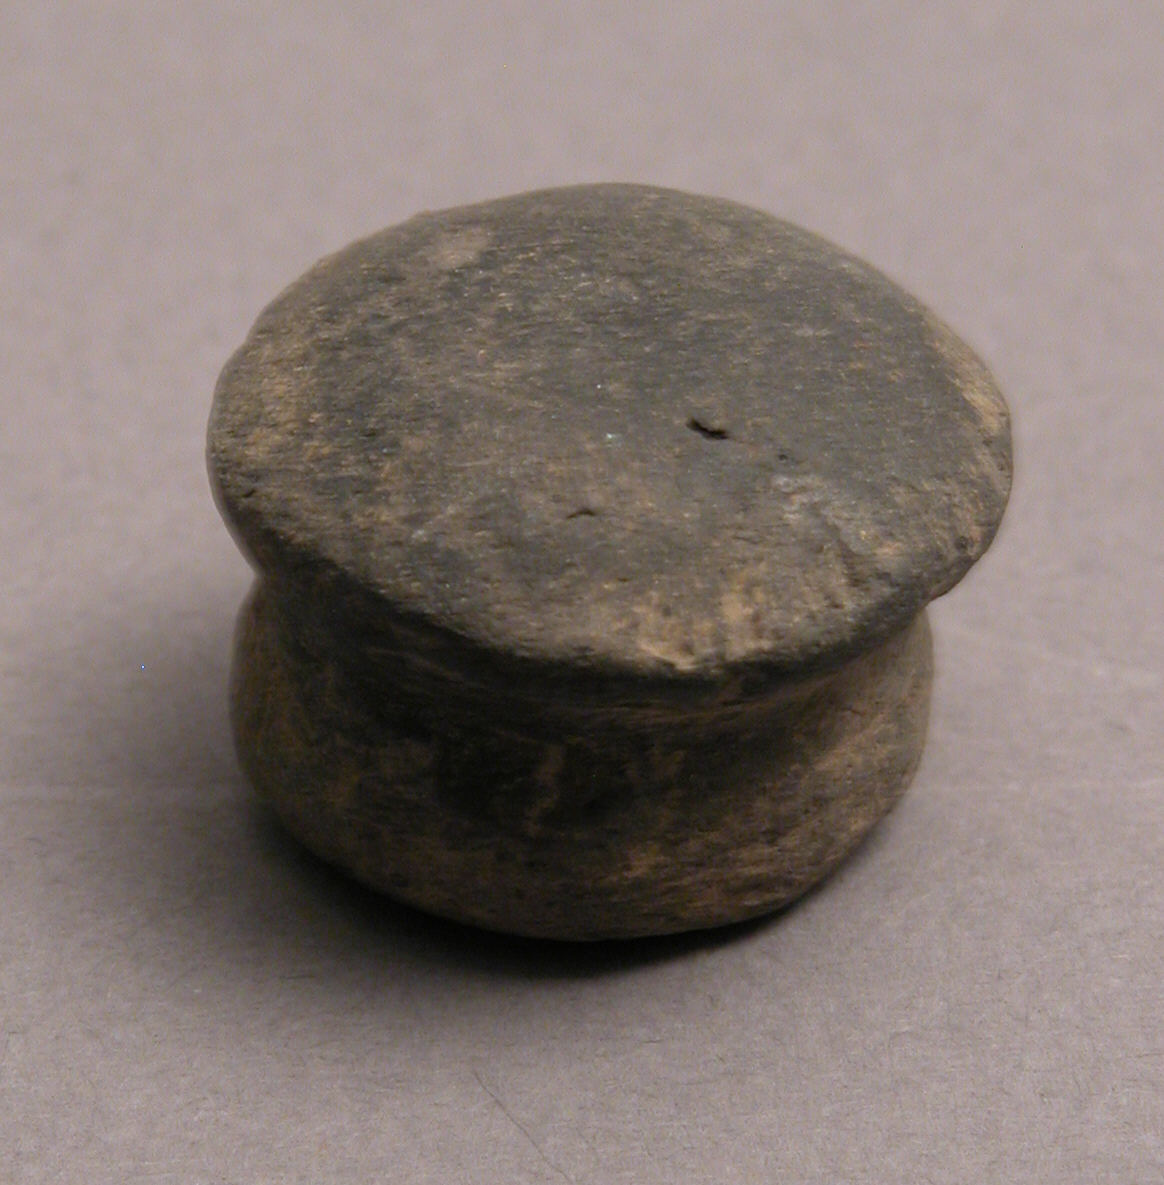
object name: game piece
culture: coptic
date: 301-700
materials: earthenware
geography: egypt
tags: games